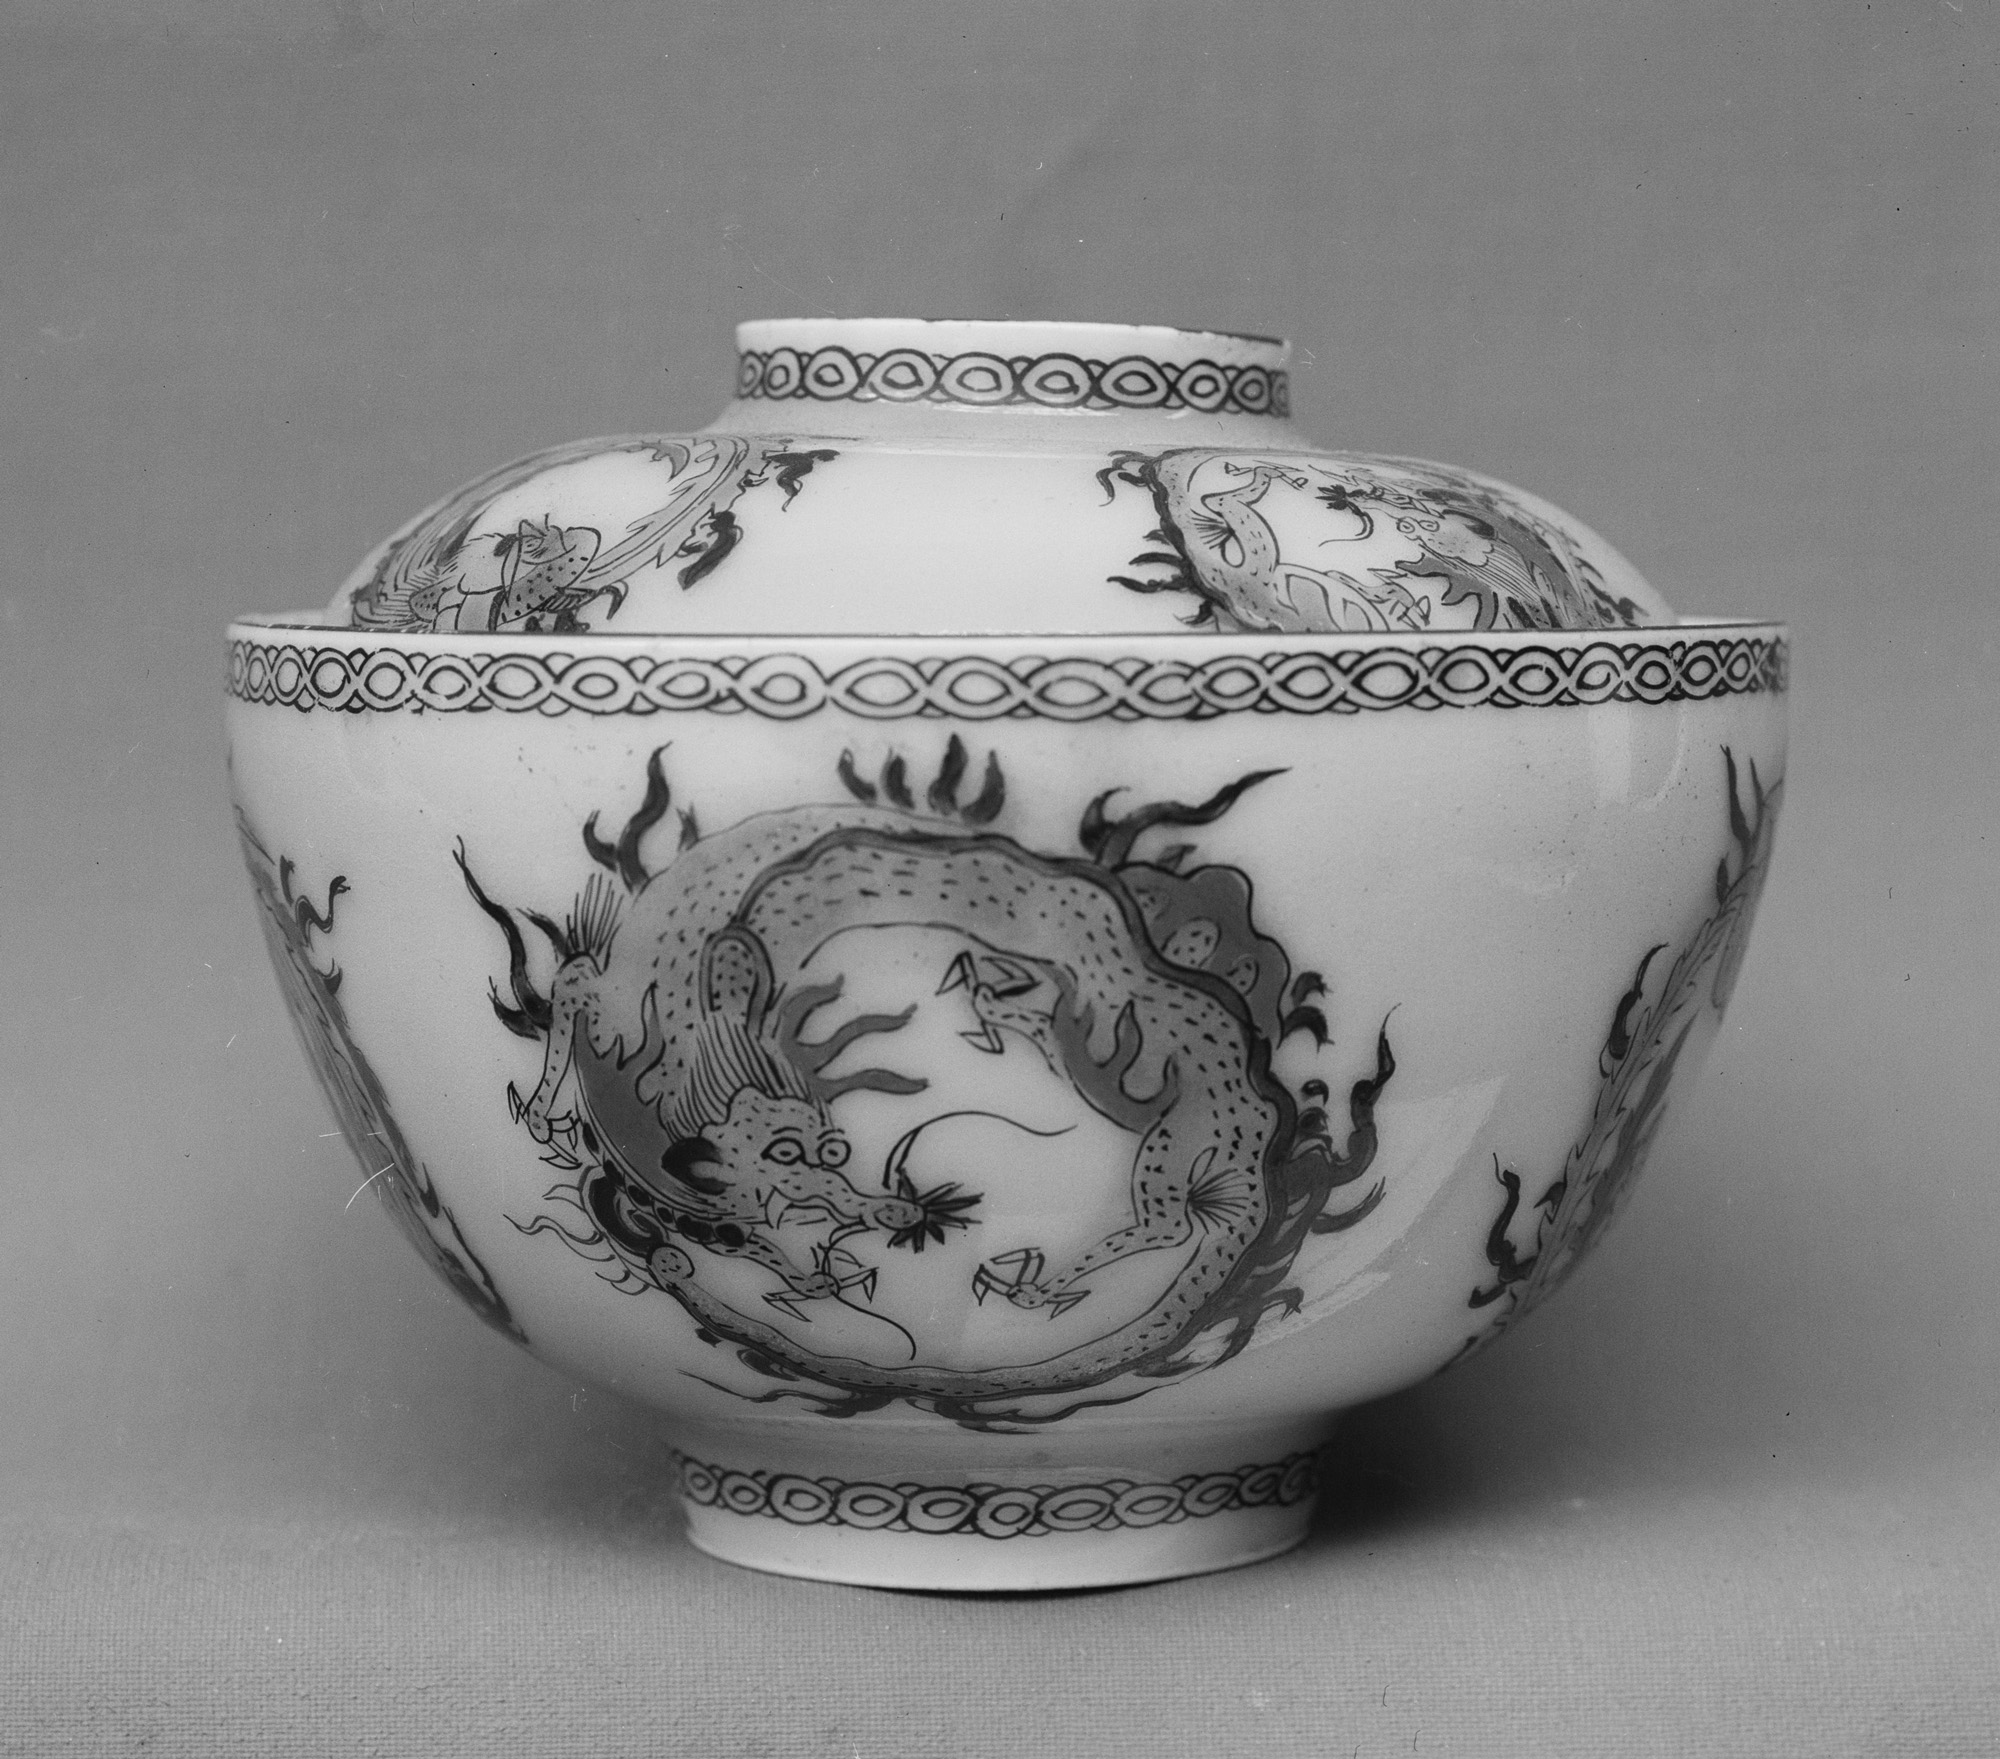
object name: cup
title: Cup with Cover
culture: japanese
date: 1780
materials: ceramic glaze, enamel, glaze, gold, porcelain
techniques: polychrome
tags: dragons